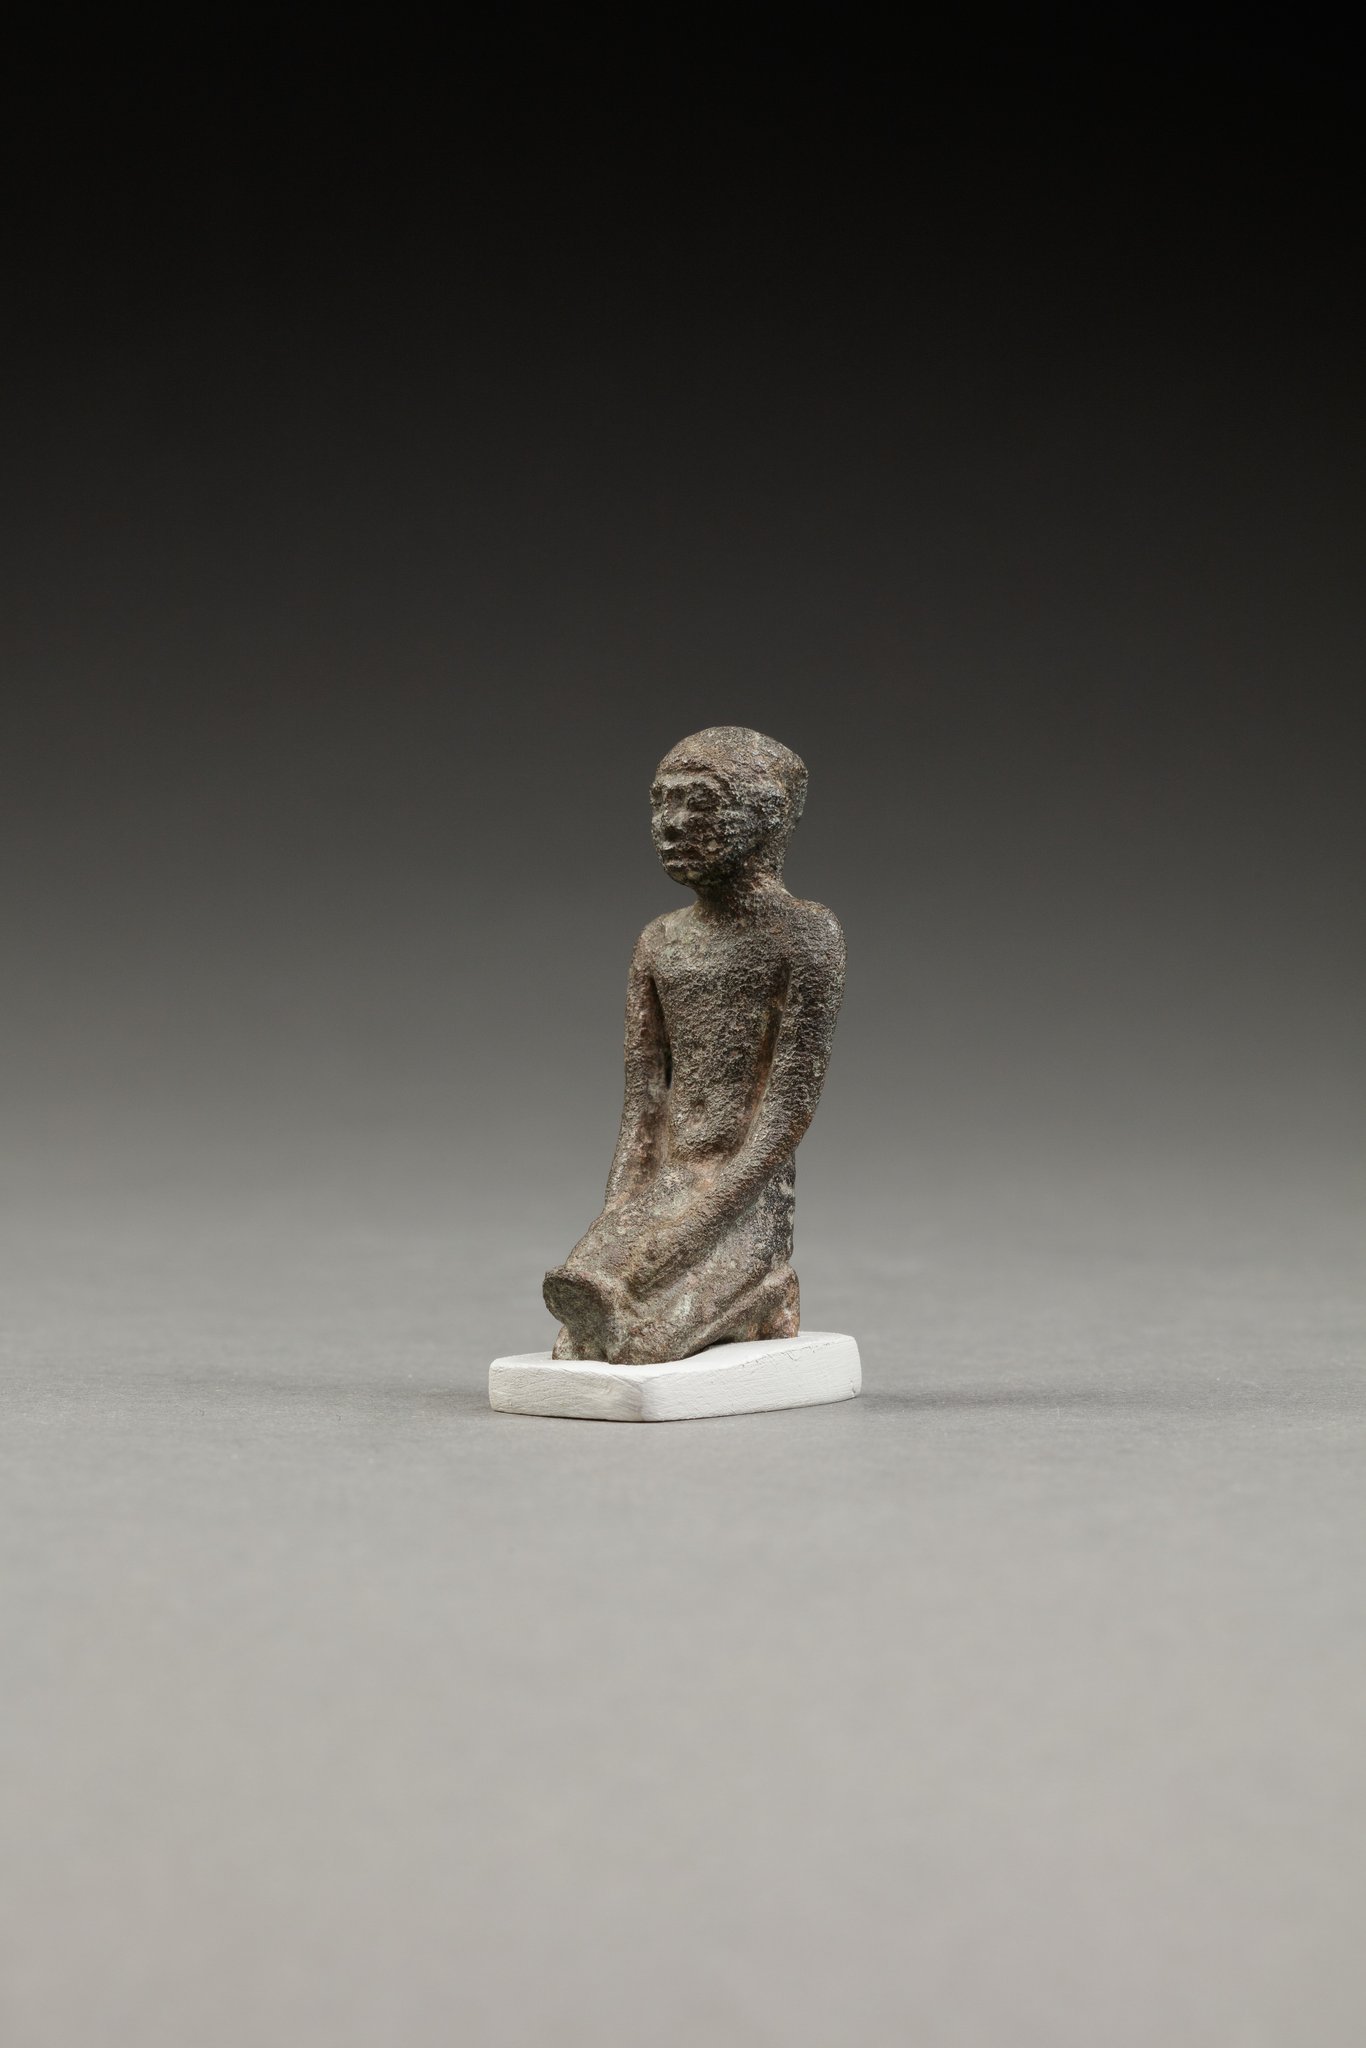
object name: priest, jar, libation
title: Kneeling Priest, Pouring Libation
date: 664-200 BCE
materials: copper alloy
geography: egypt